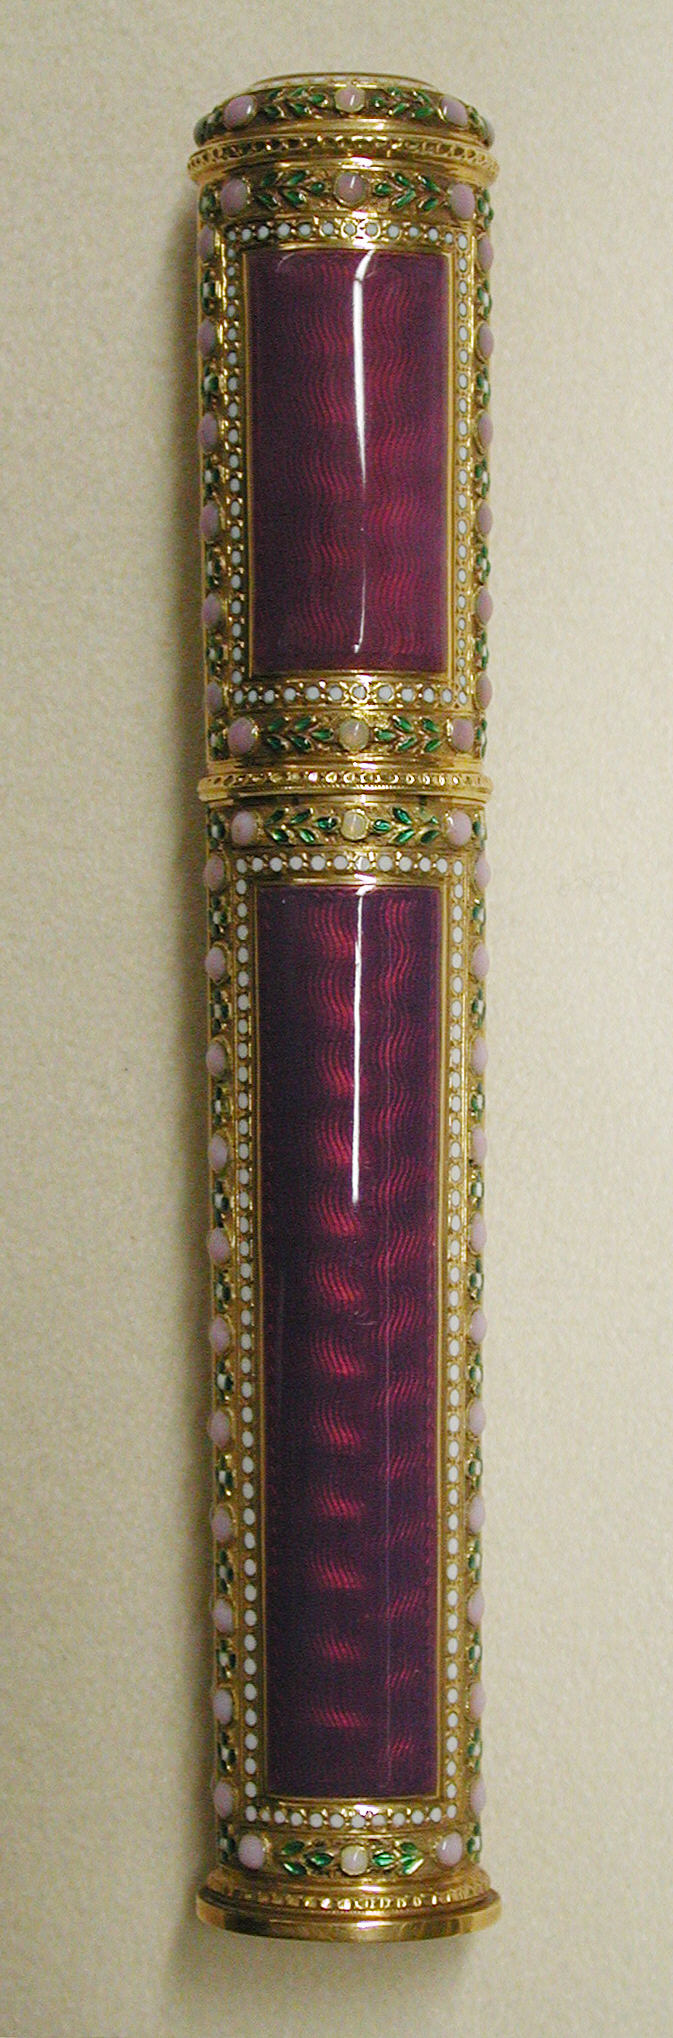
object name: étui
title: Sealing wax case (étui)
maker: joseph etienne blerzy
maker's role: maker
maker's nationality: french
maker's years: 1750-1806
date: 1783-1784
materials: enamel, gold